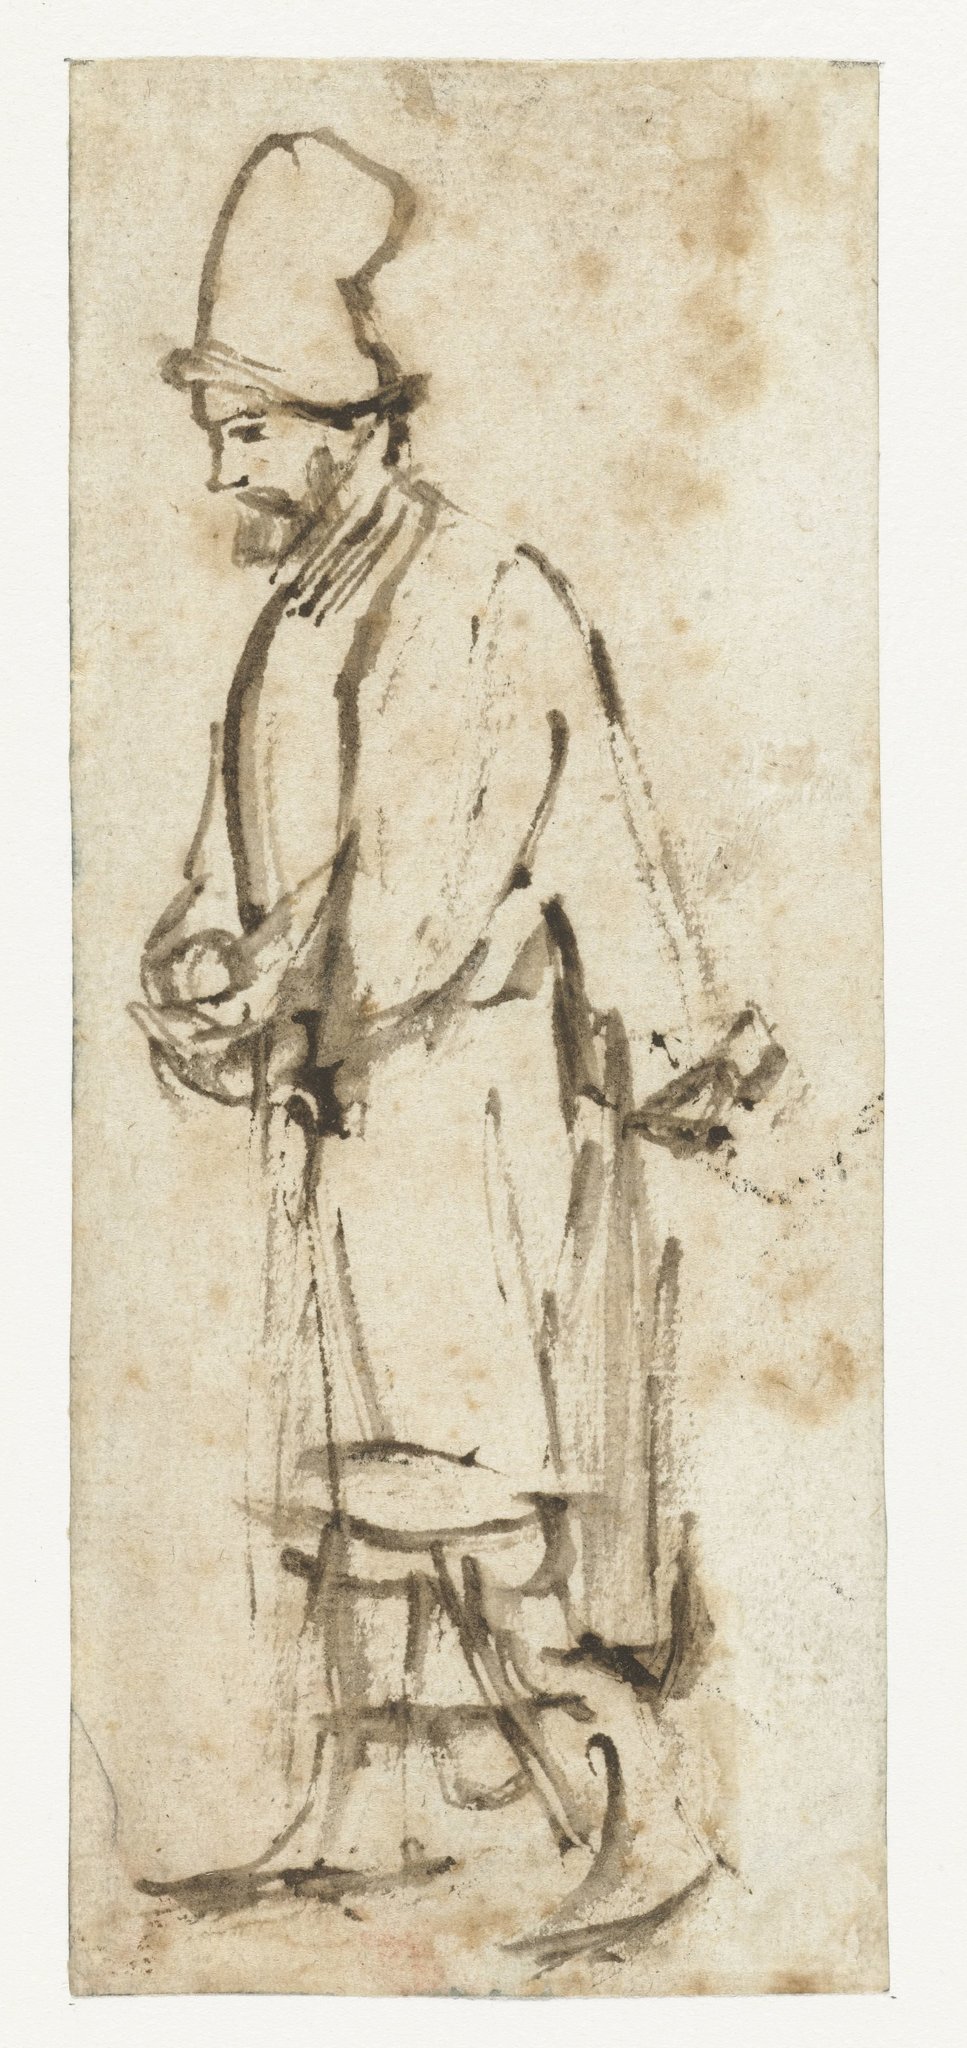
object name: drawing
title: Walking Man in a High Cap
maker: rembrandt van rijn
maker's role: draughtsman, painter, print maker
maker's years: 1606-1669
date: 1655-1660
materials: ink, paper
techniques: pen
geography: amsterdam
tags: head-gear: cap (+ men's clothes)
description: These drawings were made about twenty years apart. They were probably part of larger studies with numerous figures. Such sheets were often cut into pieces by dealers to increase their profits. The figure at the left is too tightly cropped. It is now unclear whether he is a beggar asking for alms, or perhaps a figure in a historical scene.